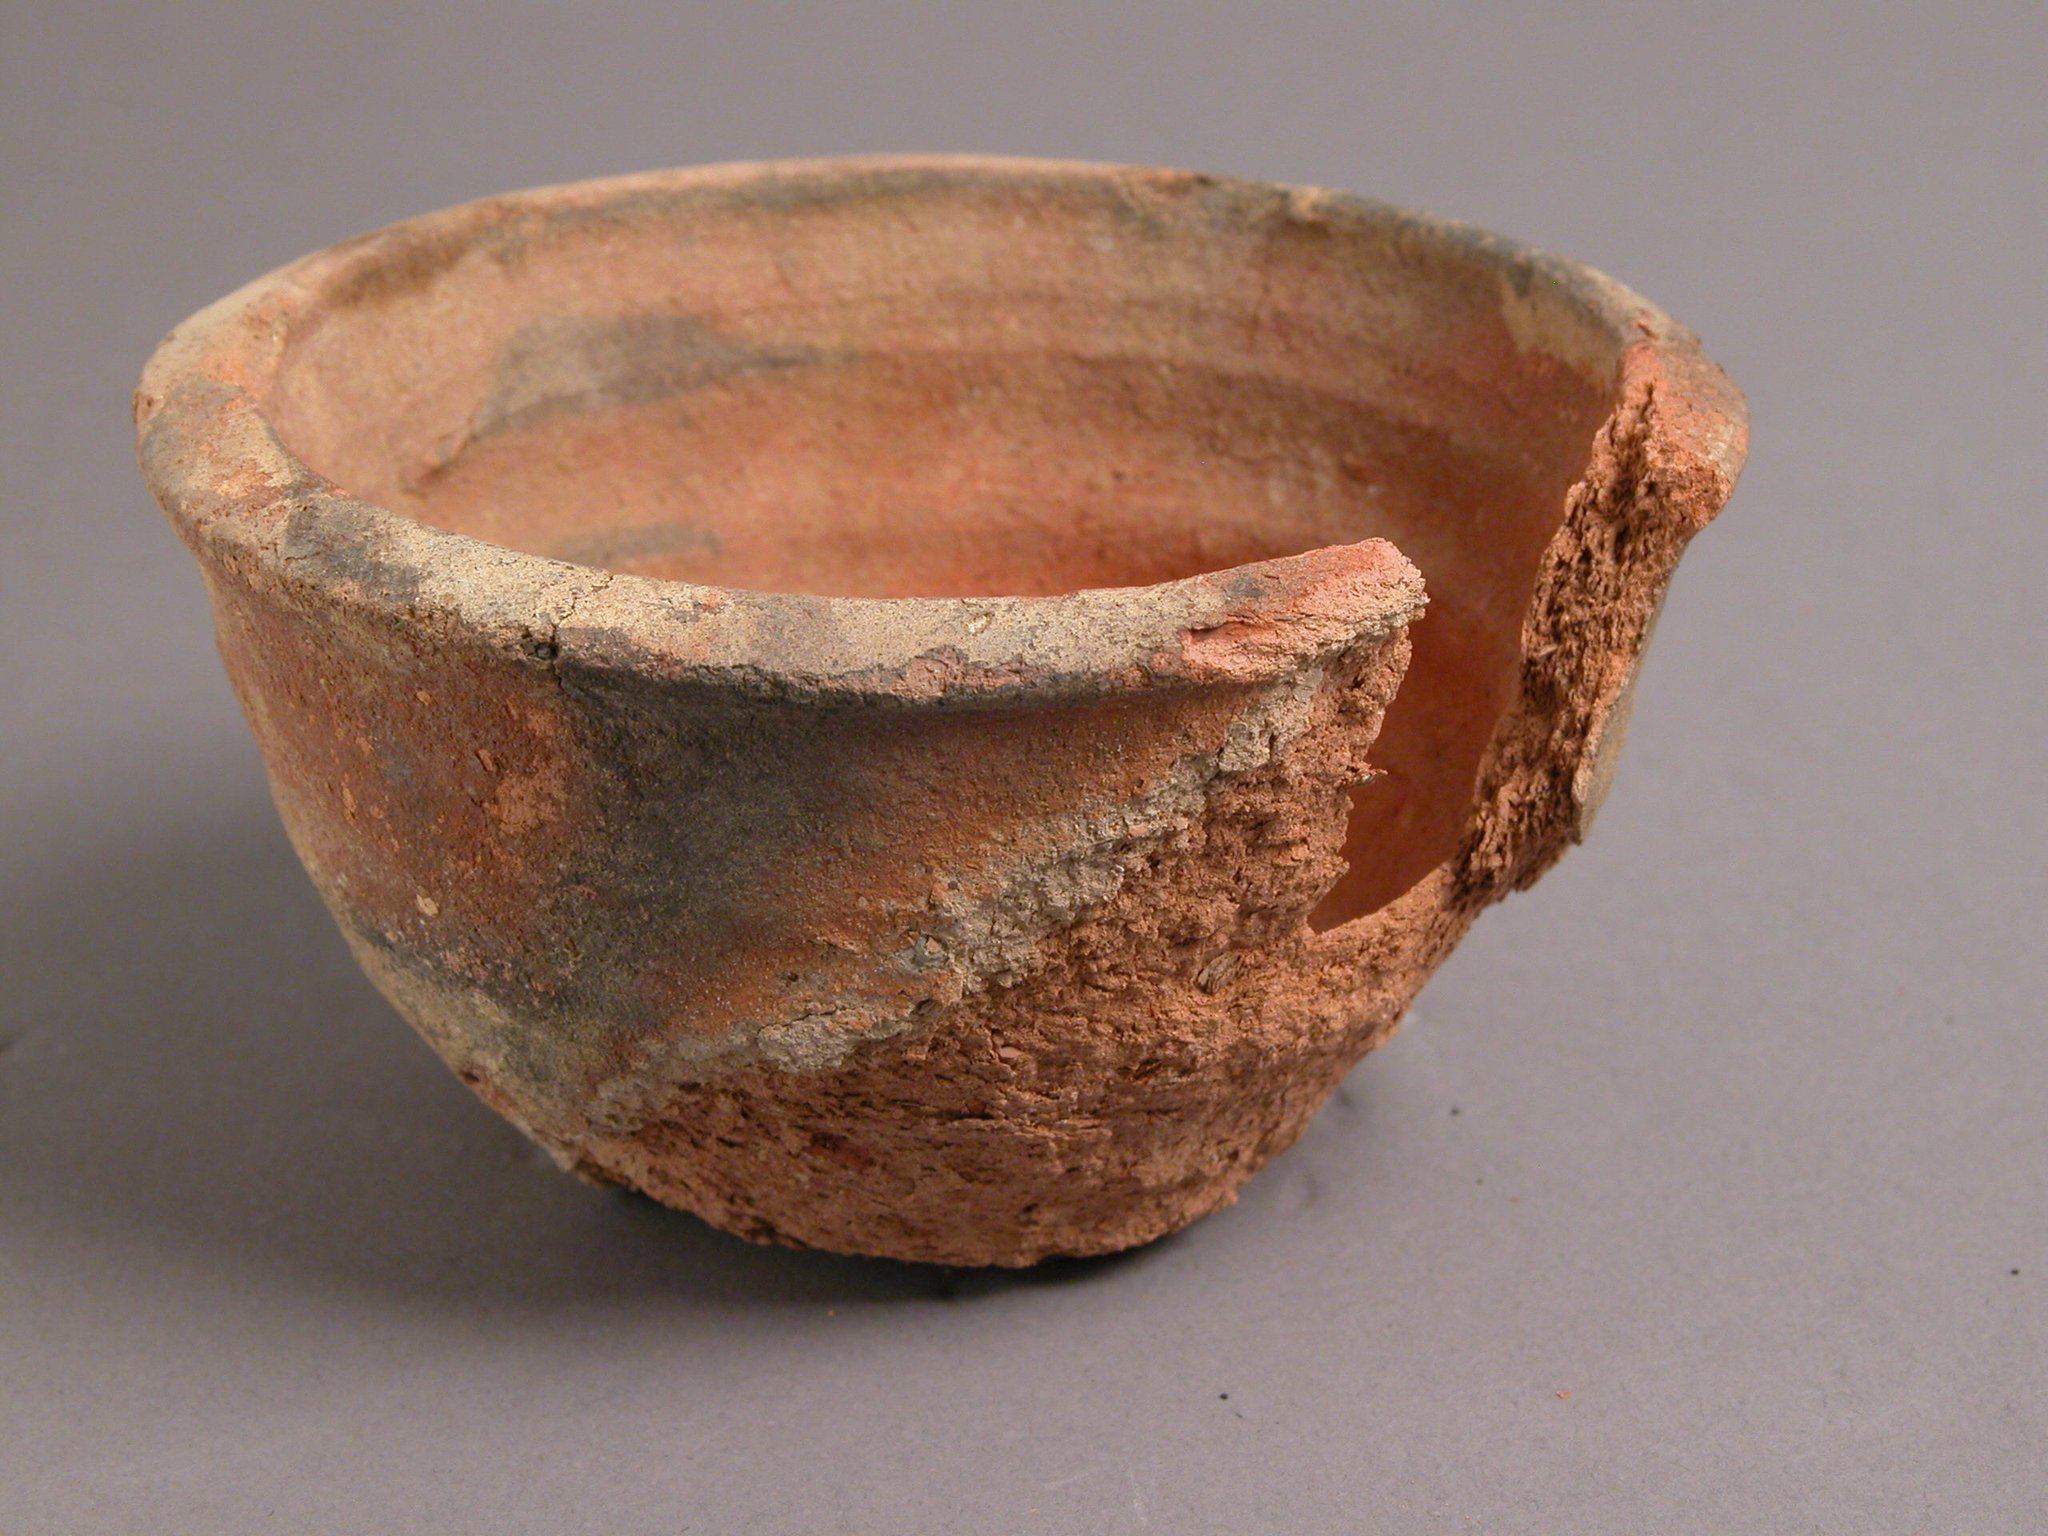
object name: bowl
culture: coptic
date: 301-700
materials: earthenware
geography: egypt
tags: bowls